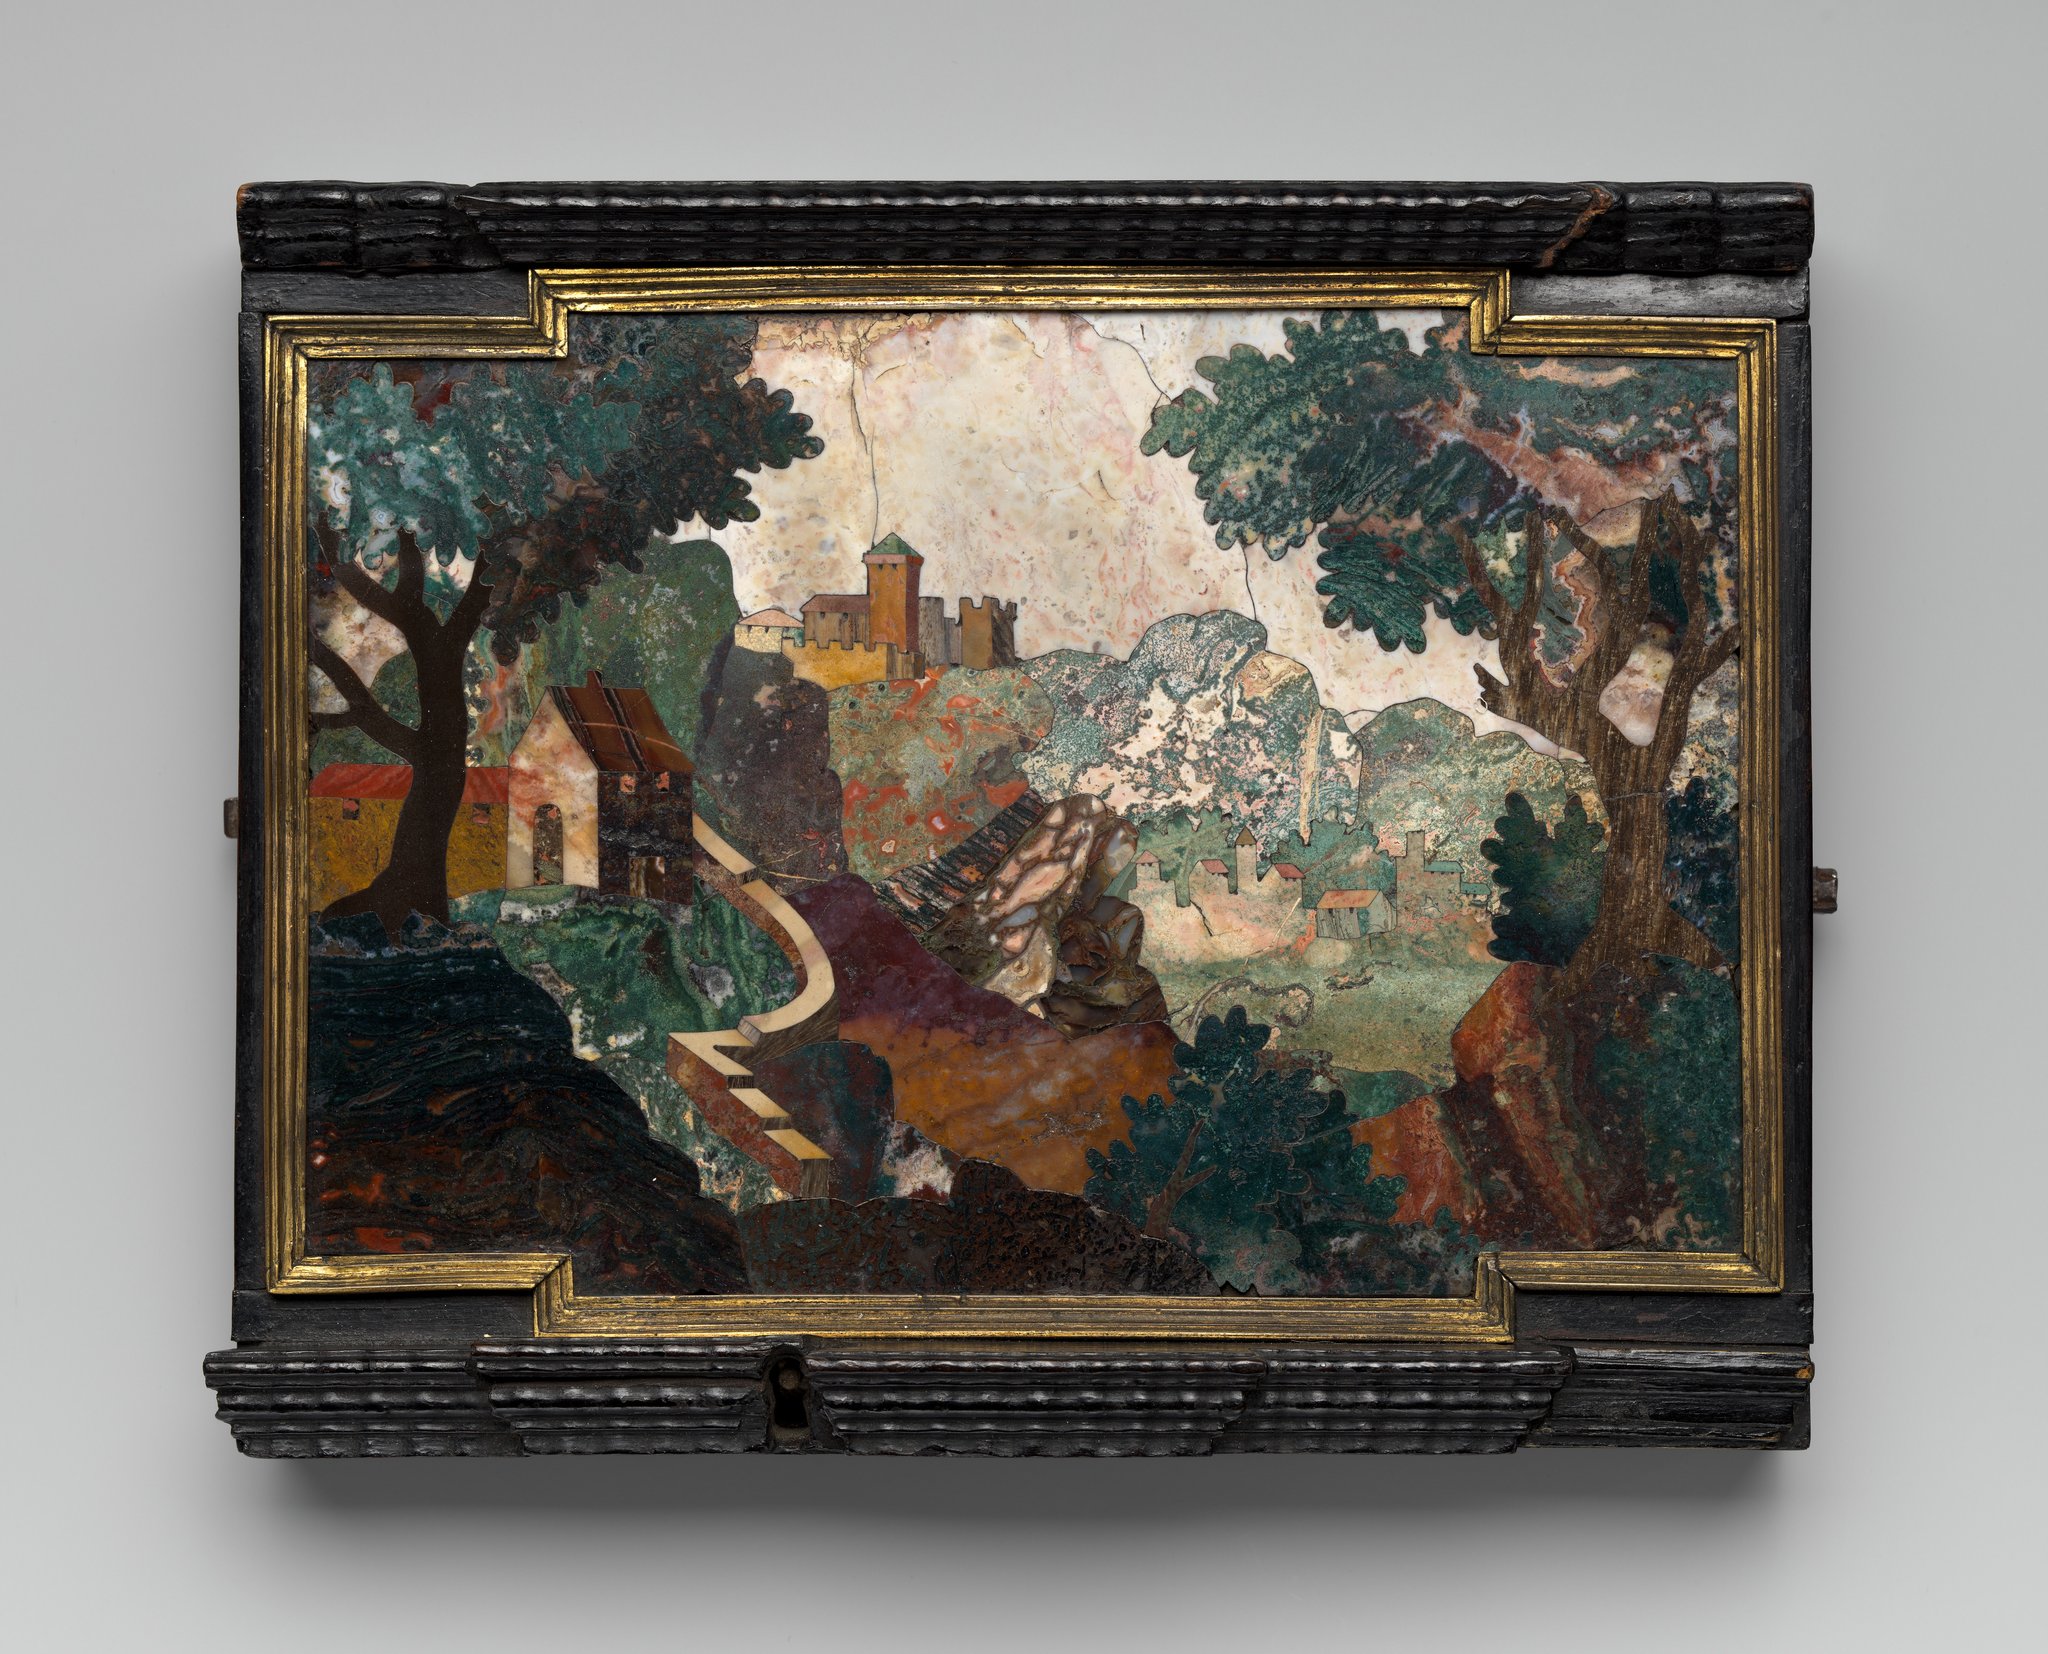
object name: panel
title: Pietre dure (hardstone) landscape scene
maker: castrucci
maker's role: maker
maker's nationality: italian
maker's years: 1580-1620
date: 1601-1700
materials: stone, wood, iron, jasper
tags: landscapes